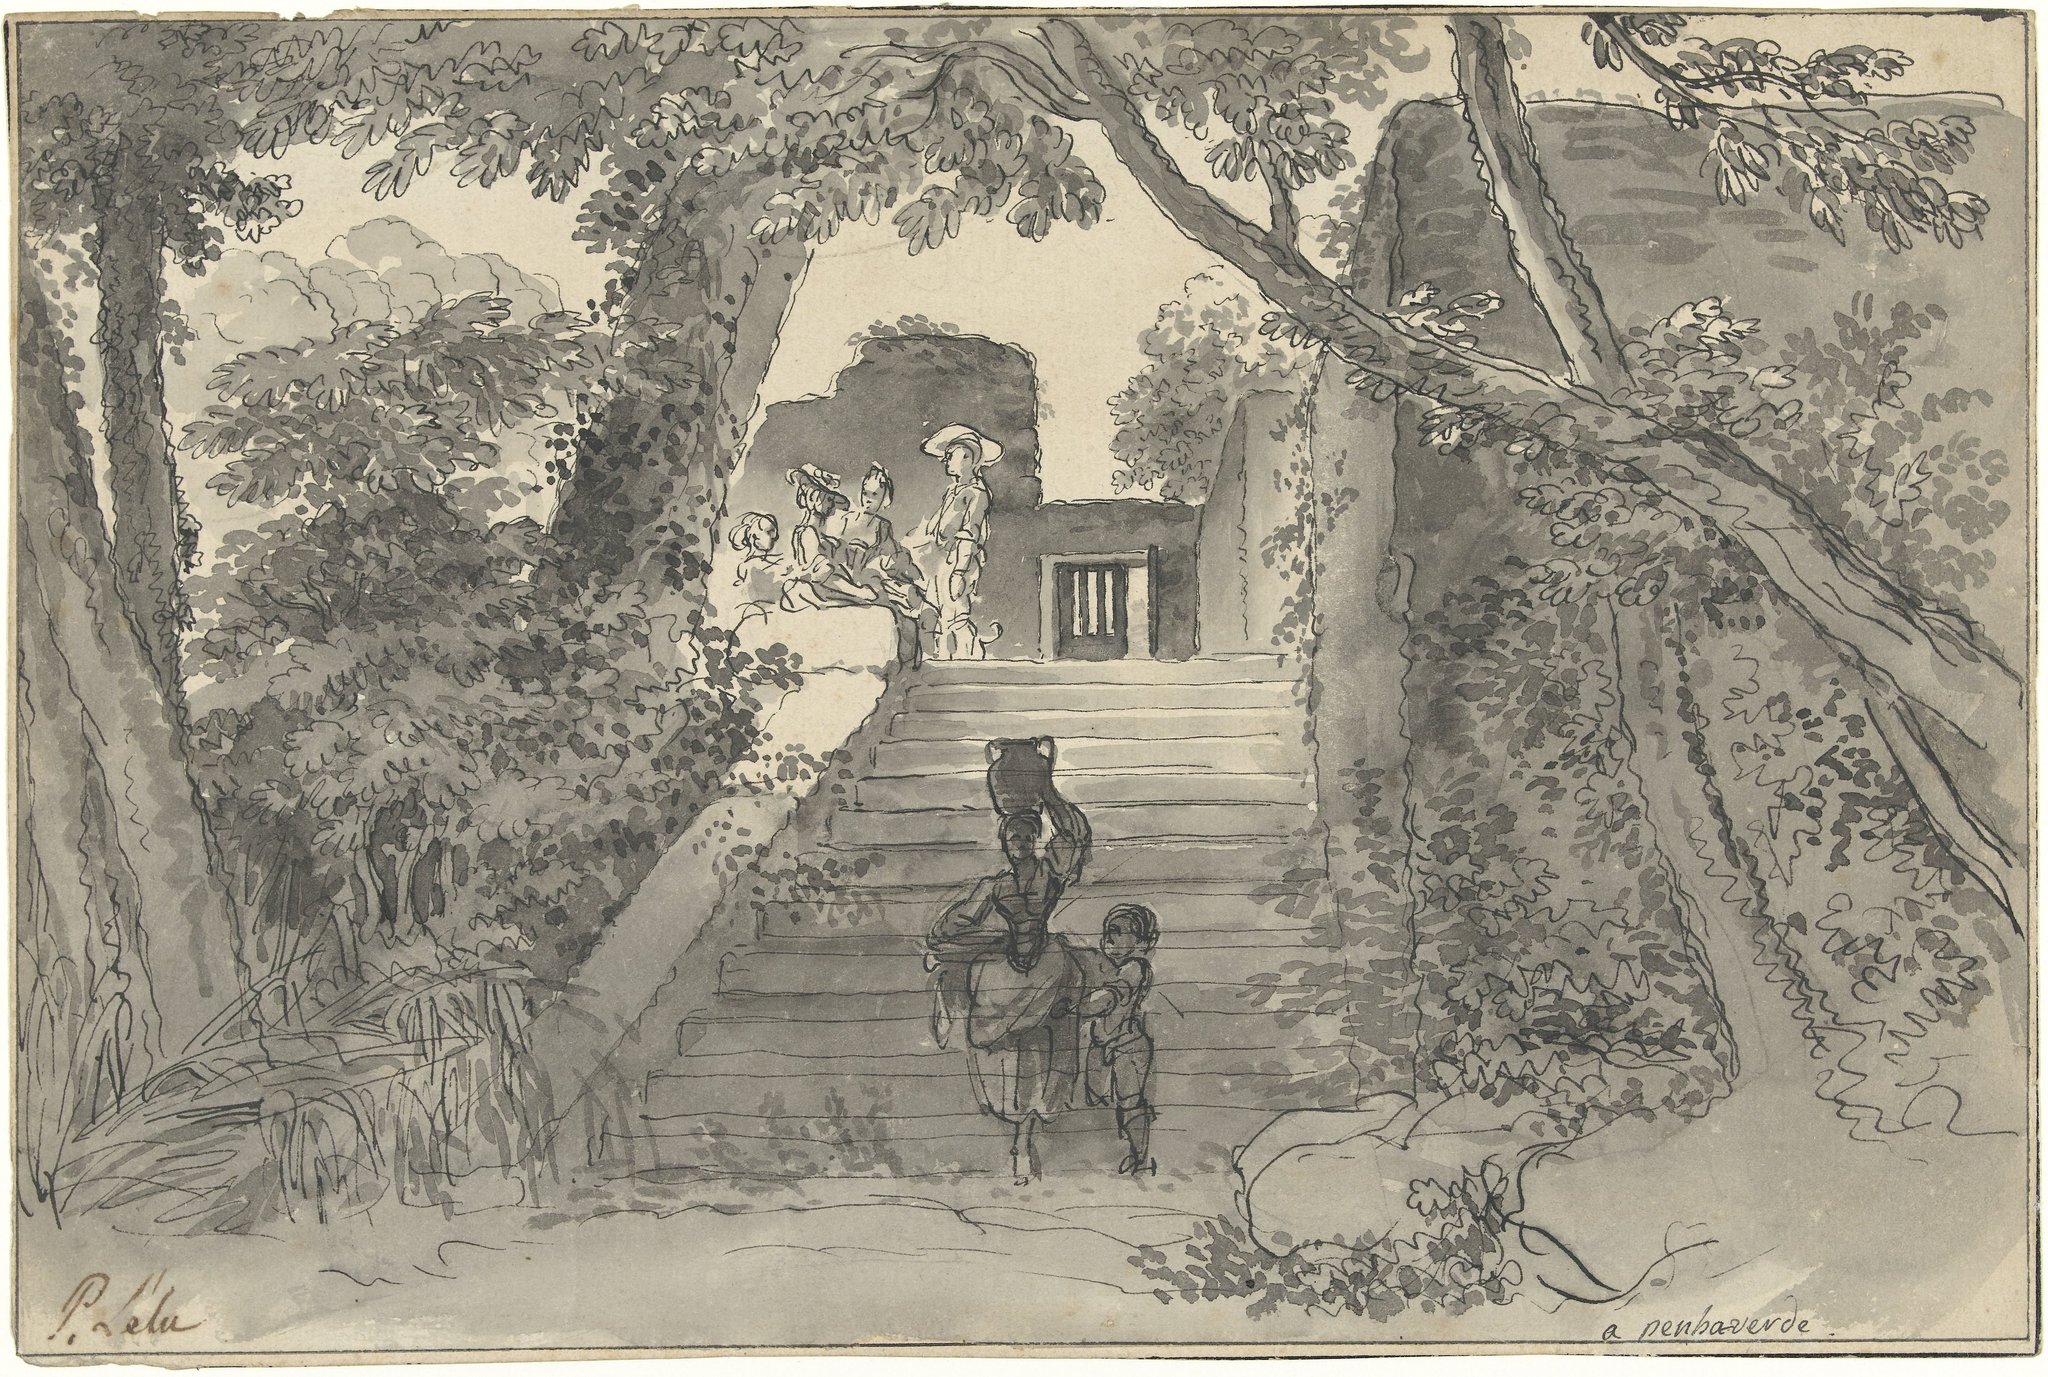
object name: drawing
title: Gezicht in de tuin van Penhaverde, Portugal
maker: pierre lelu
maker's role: draughtsman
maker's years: 1741-1810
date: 1772-1778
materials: chalk, ink, paper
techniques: brush, pen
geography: portugal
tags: park, garden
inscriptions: inscription, recto, lower right, pen and black ink: ‘a penhaverde.’, collector's mark: Lugt 2228, annotation, verso, lower left, pencil: ‘n. 1844’, annotation, verso, upper left, pencil: ‘lhesh’, signature, recto, lower left, pen and brown ink: ‘P. Lélu’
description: Lélu, leerling van Boucher en Doyen, maakte, behalve een aantal reizen naar Italië, omstreeks 1775 ook een reis naar Portugal. Daar tekende hij de tuin van het uit de 16e eeuw daterende Penhaverde, een niet ver van Lissabon gelegen landgoed van Joao de Castro, de vierde onderkoning van Indië.